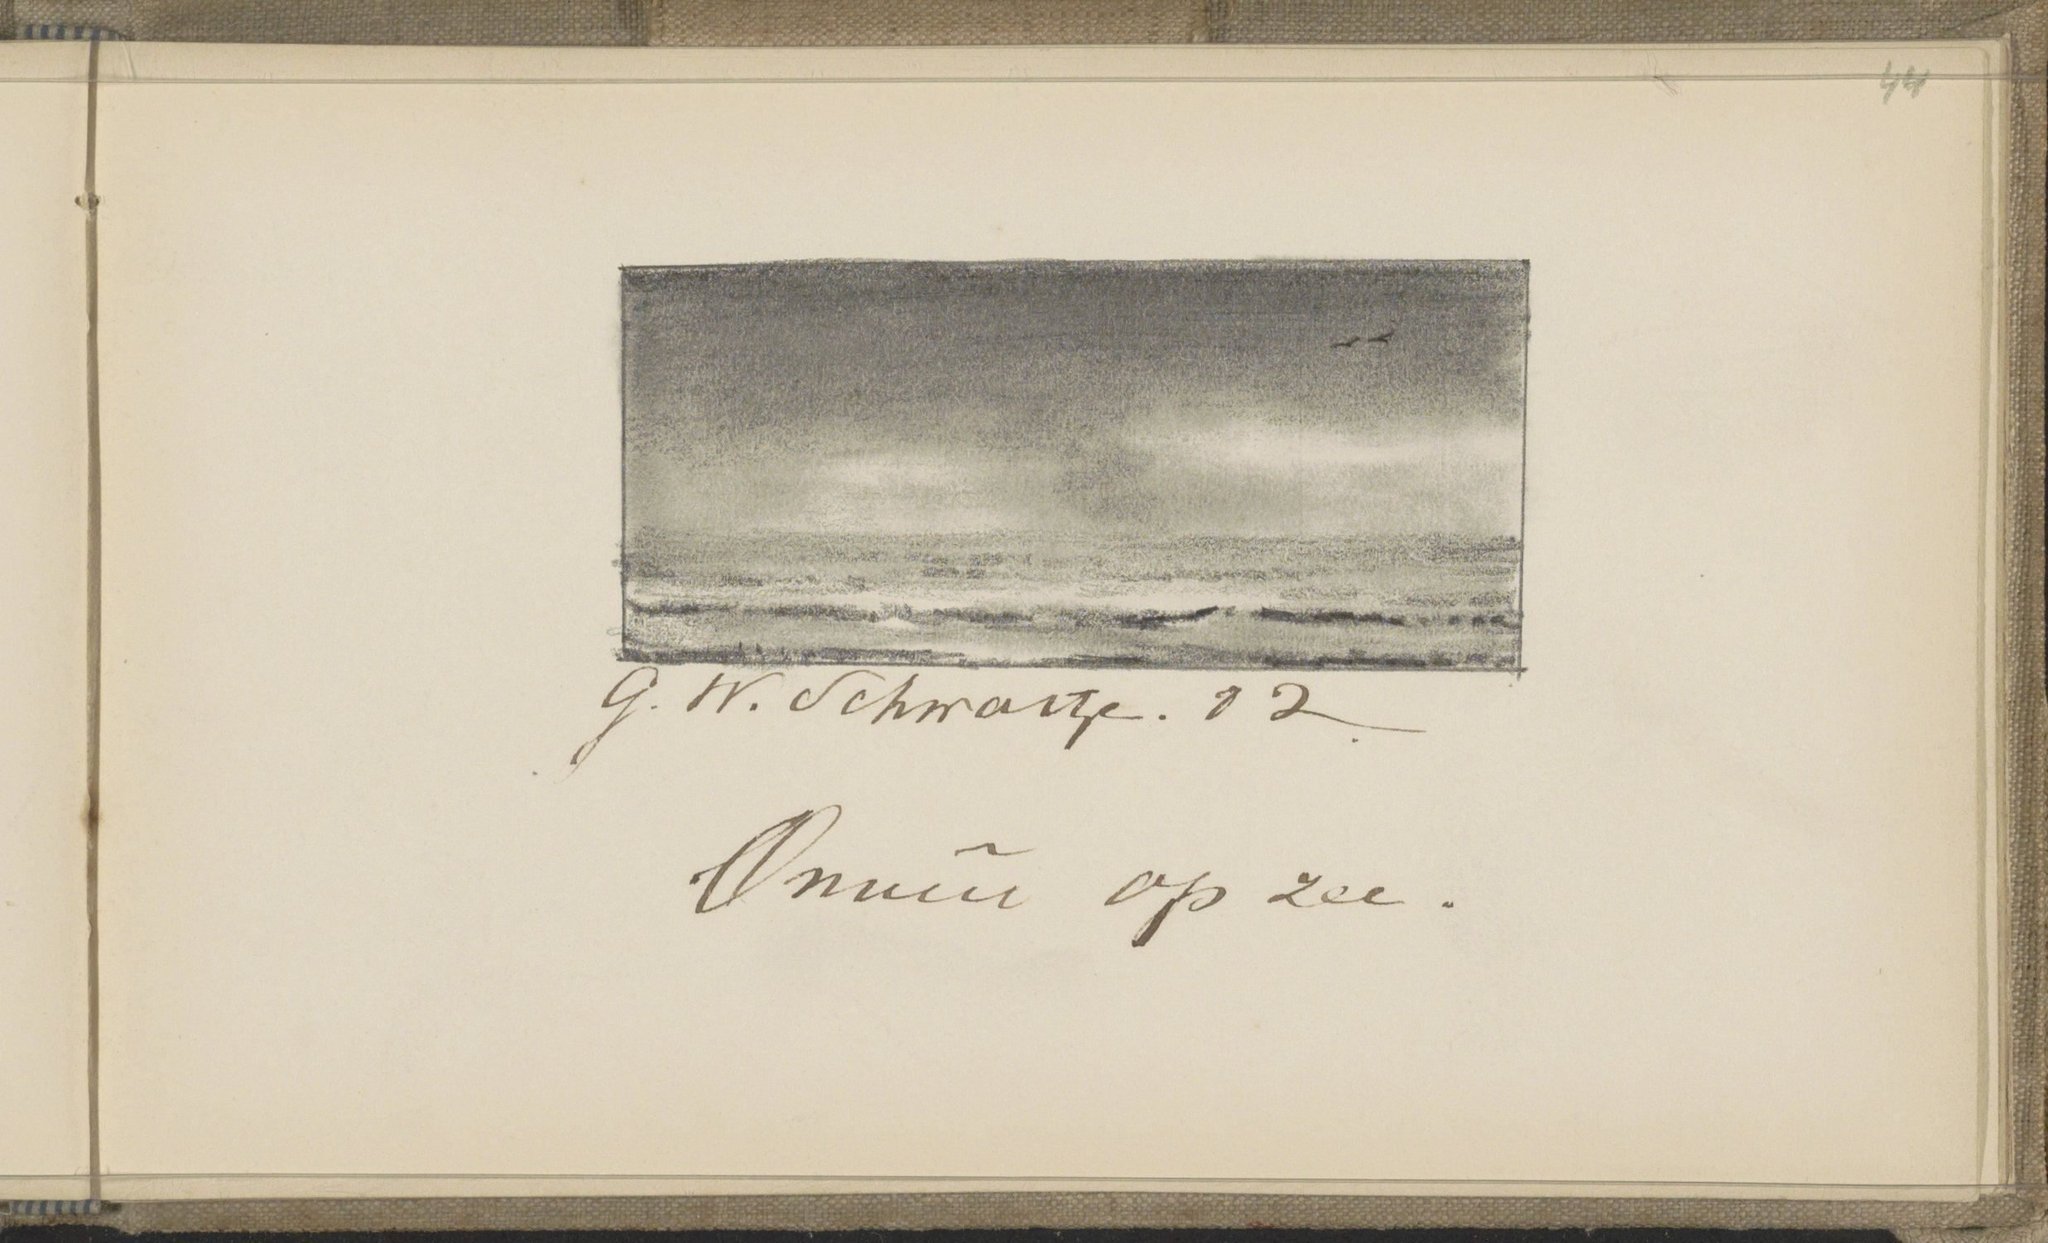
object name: sketchbook leaf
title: Onweer op zee.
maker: george washington schwartze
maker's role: draughtsman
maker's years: 1857-1909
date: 1882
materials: paper, pencil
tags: sea (seascape), lightning, flash of lightning, thunderbolt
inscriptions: title: ‘Onweer op zee.’, signature and date: ‘G.W. Schwartze. 82.’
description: Tekening in een kader. Blad 44 recto uit een schetsboek met 54 bladen.